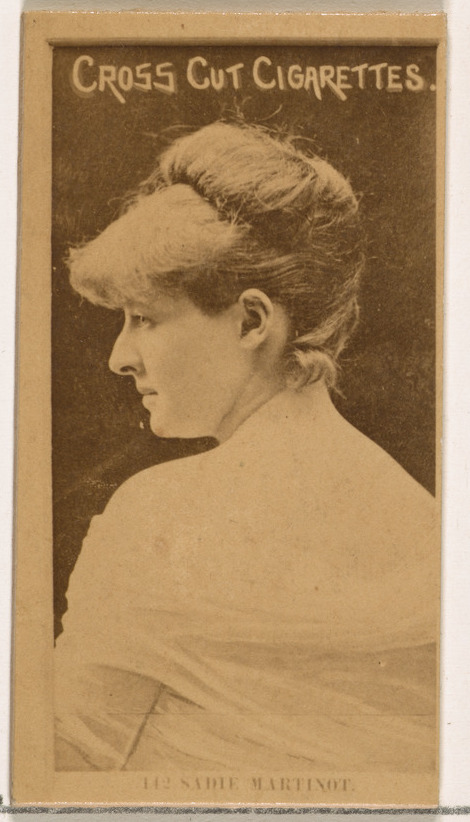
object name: print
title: Card Number 142, Miss Sadie Martinot, from the Actors and Actresses series (N145-2) issued by Duke Sons & Co. to promote Cross Cut Cigarettes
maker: w. duke, sons & co.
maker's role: publisher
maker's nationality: american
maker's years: 1870-1920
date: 1880-1889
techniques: albumen silver print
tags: women,actresses